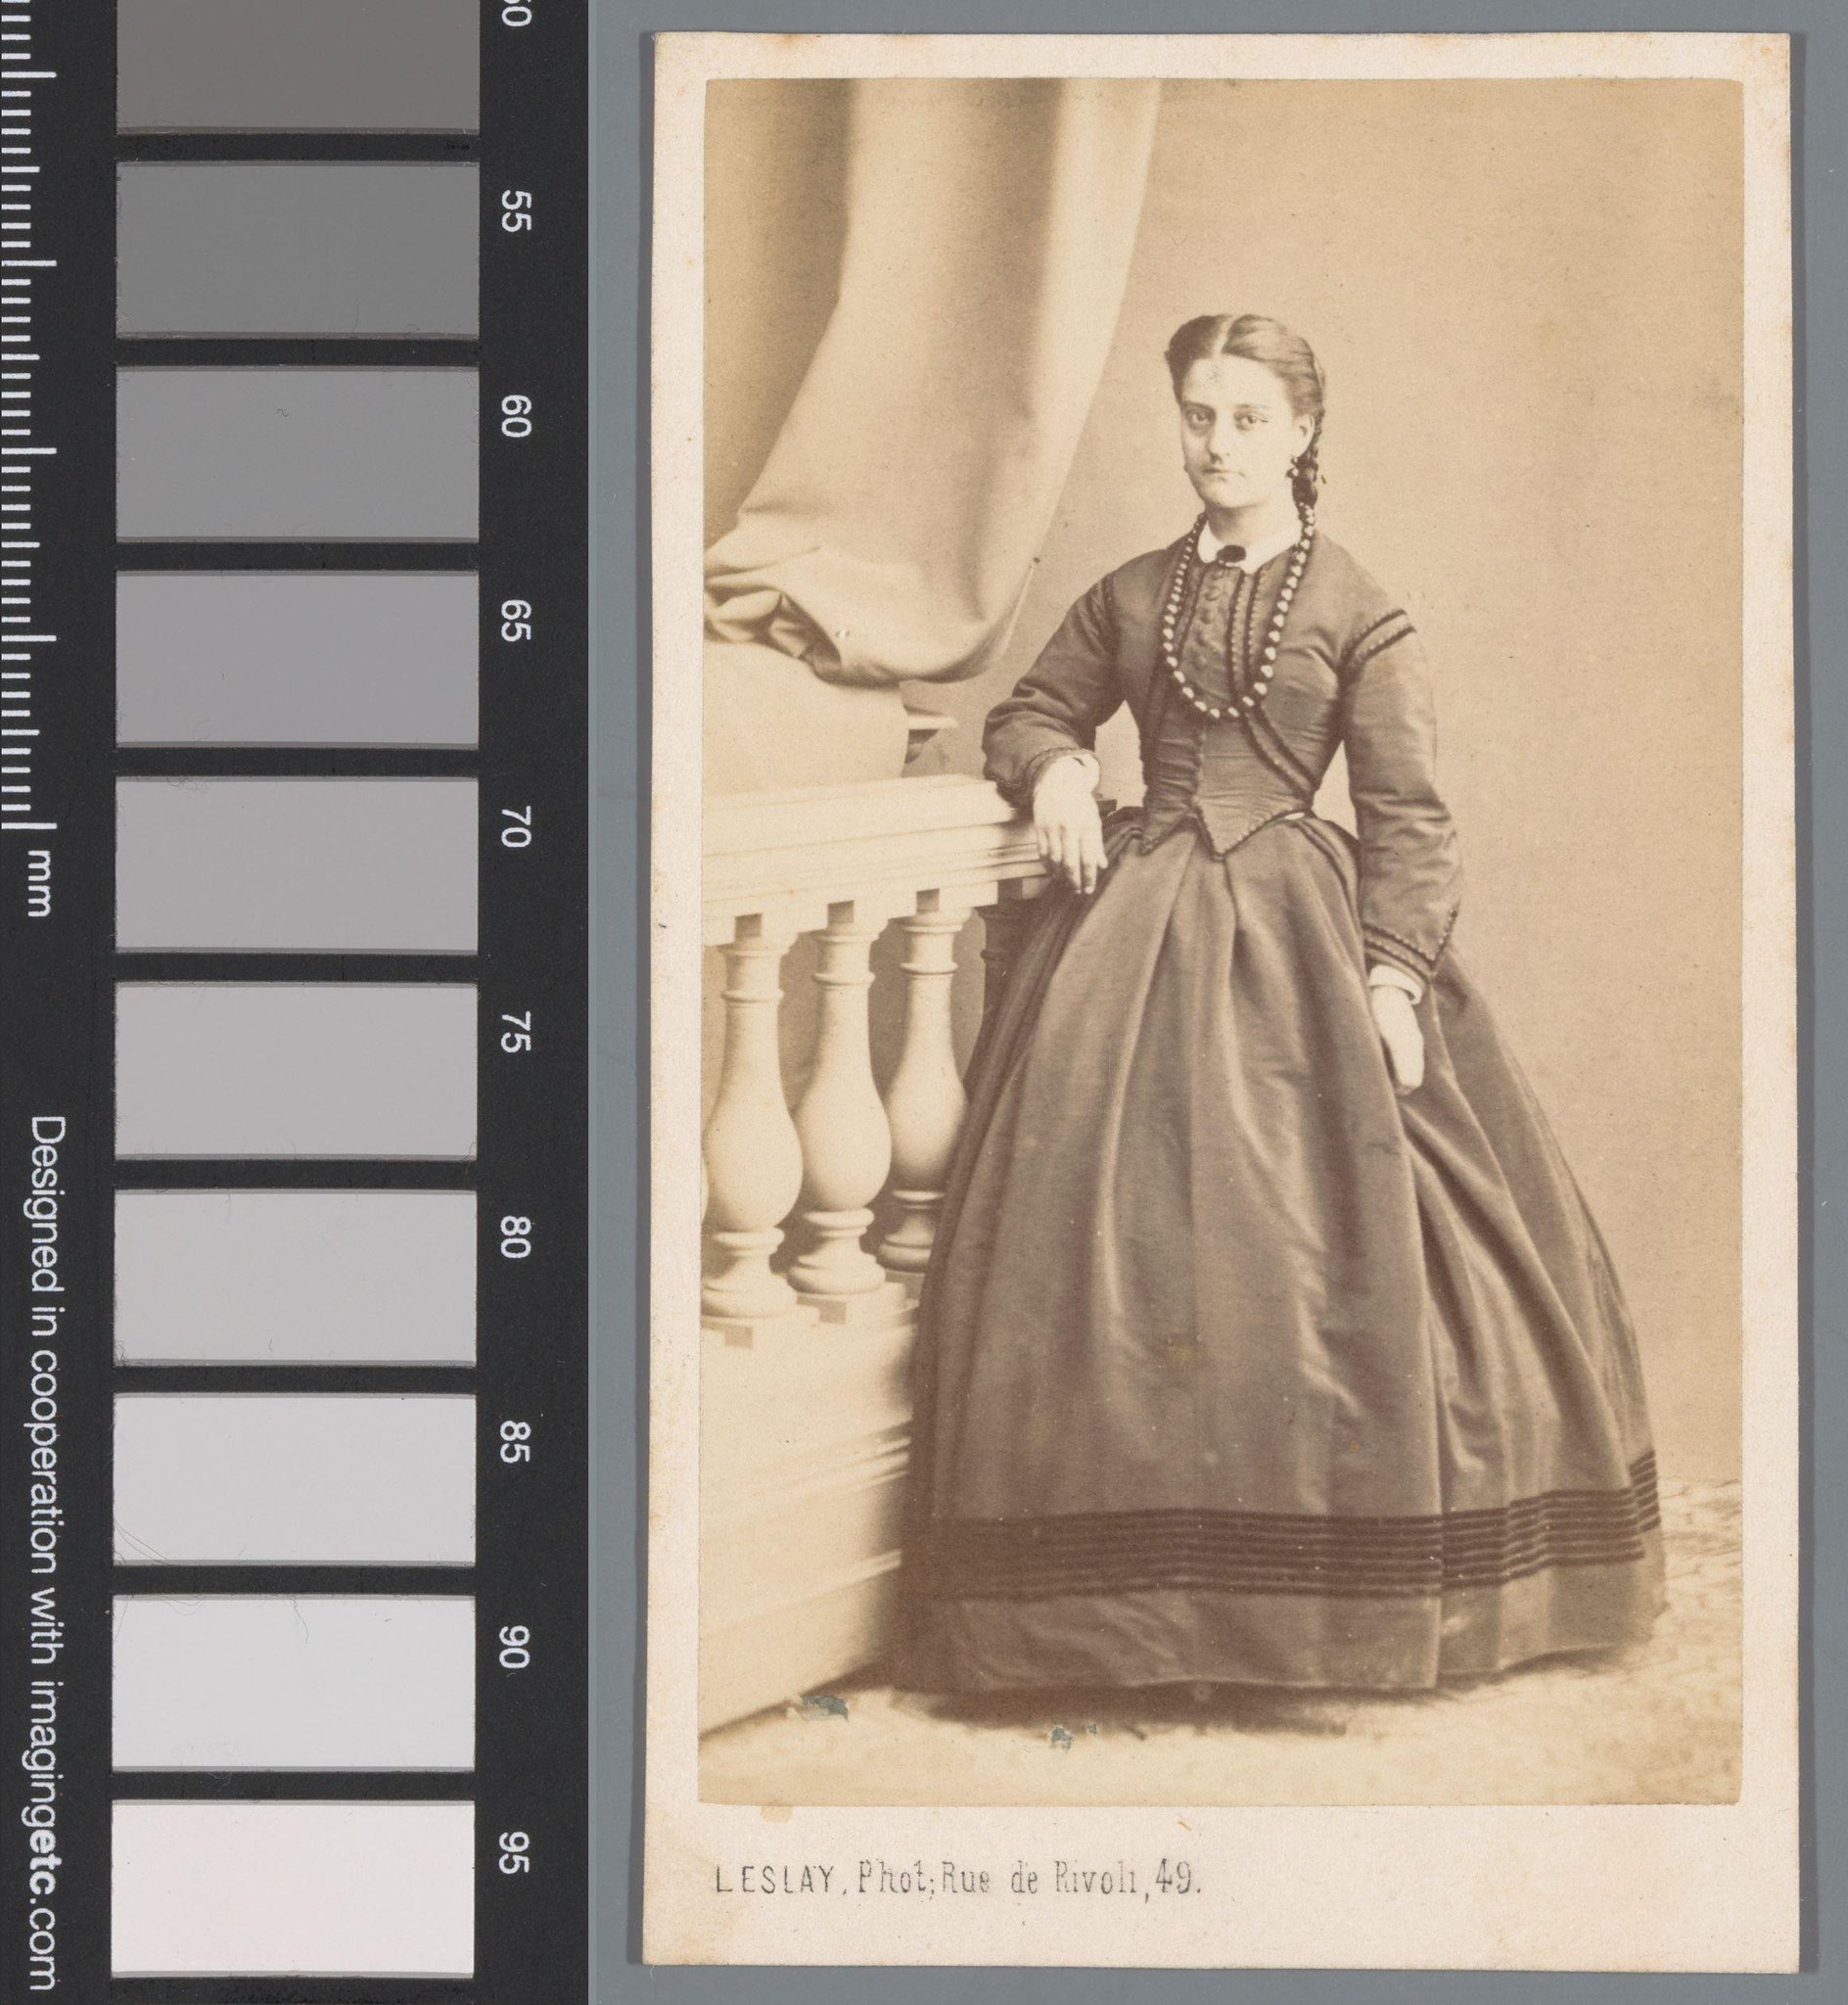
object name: photograph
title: Portret van een onbekende vrouw bij een balustrade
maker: auguste leslay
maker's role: fotograaf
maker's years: 1832-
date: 1855-1875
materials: cardboard, paper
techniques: albumen print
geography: paris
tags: adult woman, anonymous historical person portrayed, paris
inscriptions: inscription: ‘Photographie/ Leslay/ 49 Rue de Rivoli 49/ Paris’, inscription: ‘Leslay, Phot; Rue de Rivoli, 49.’